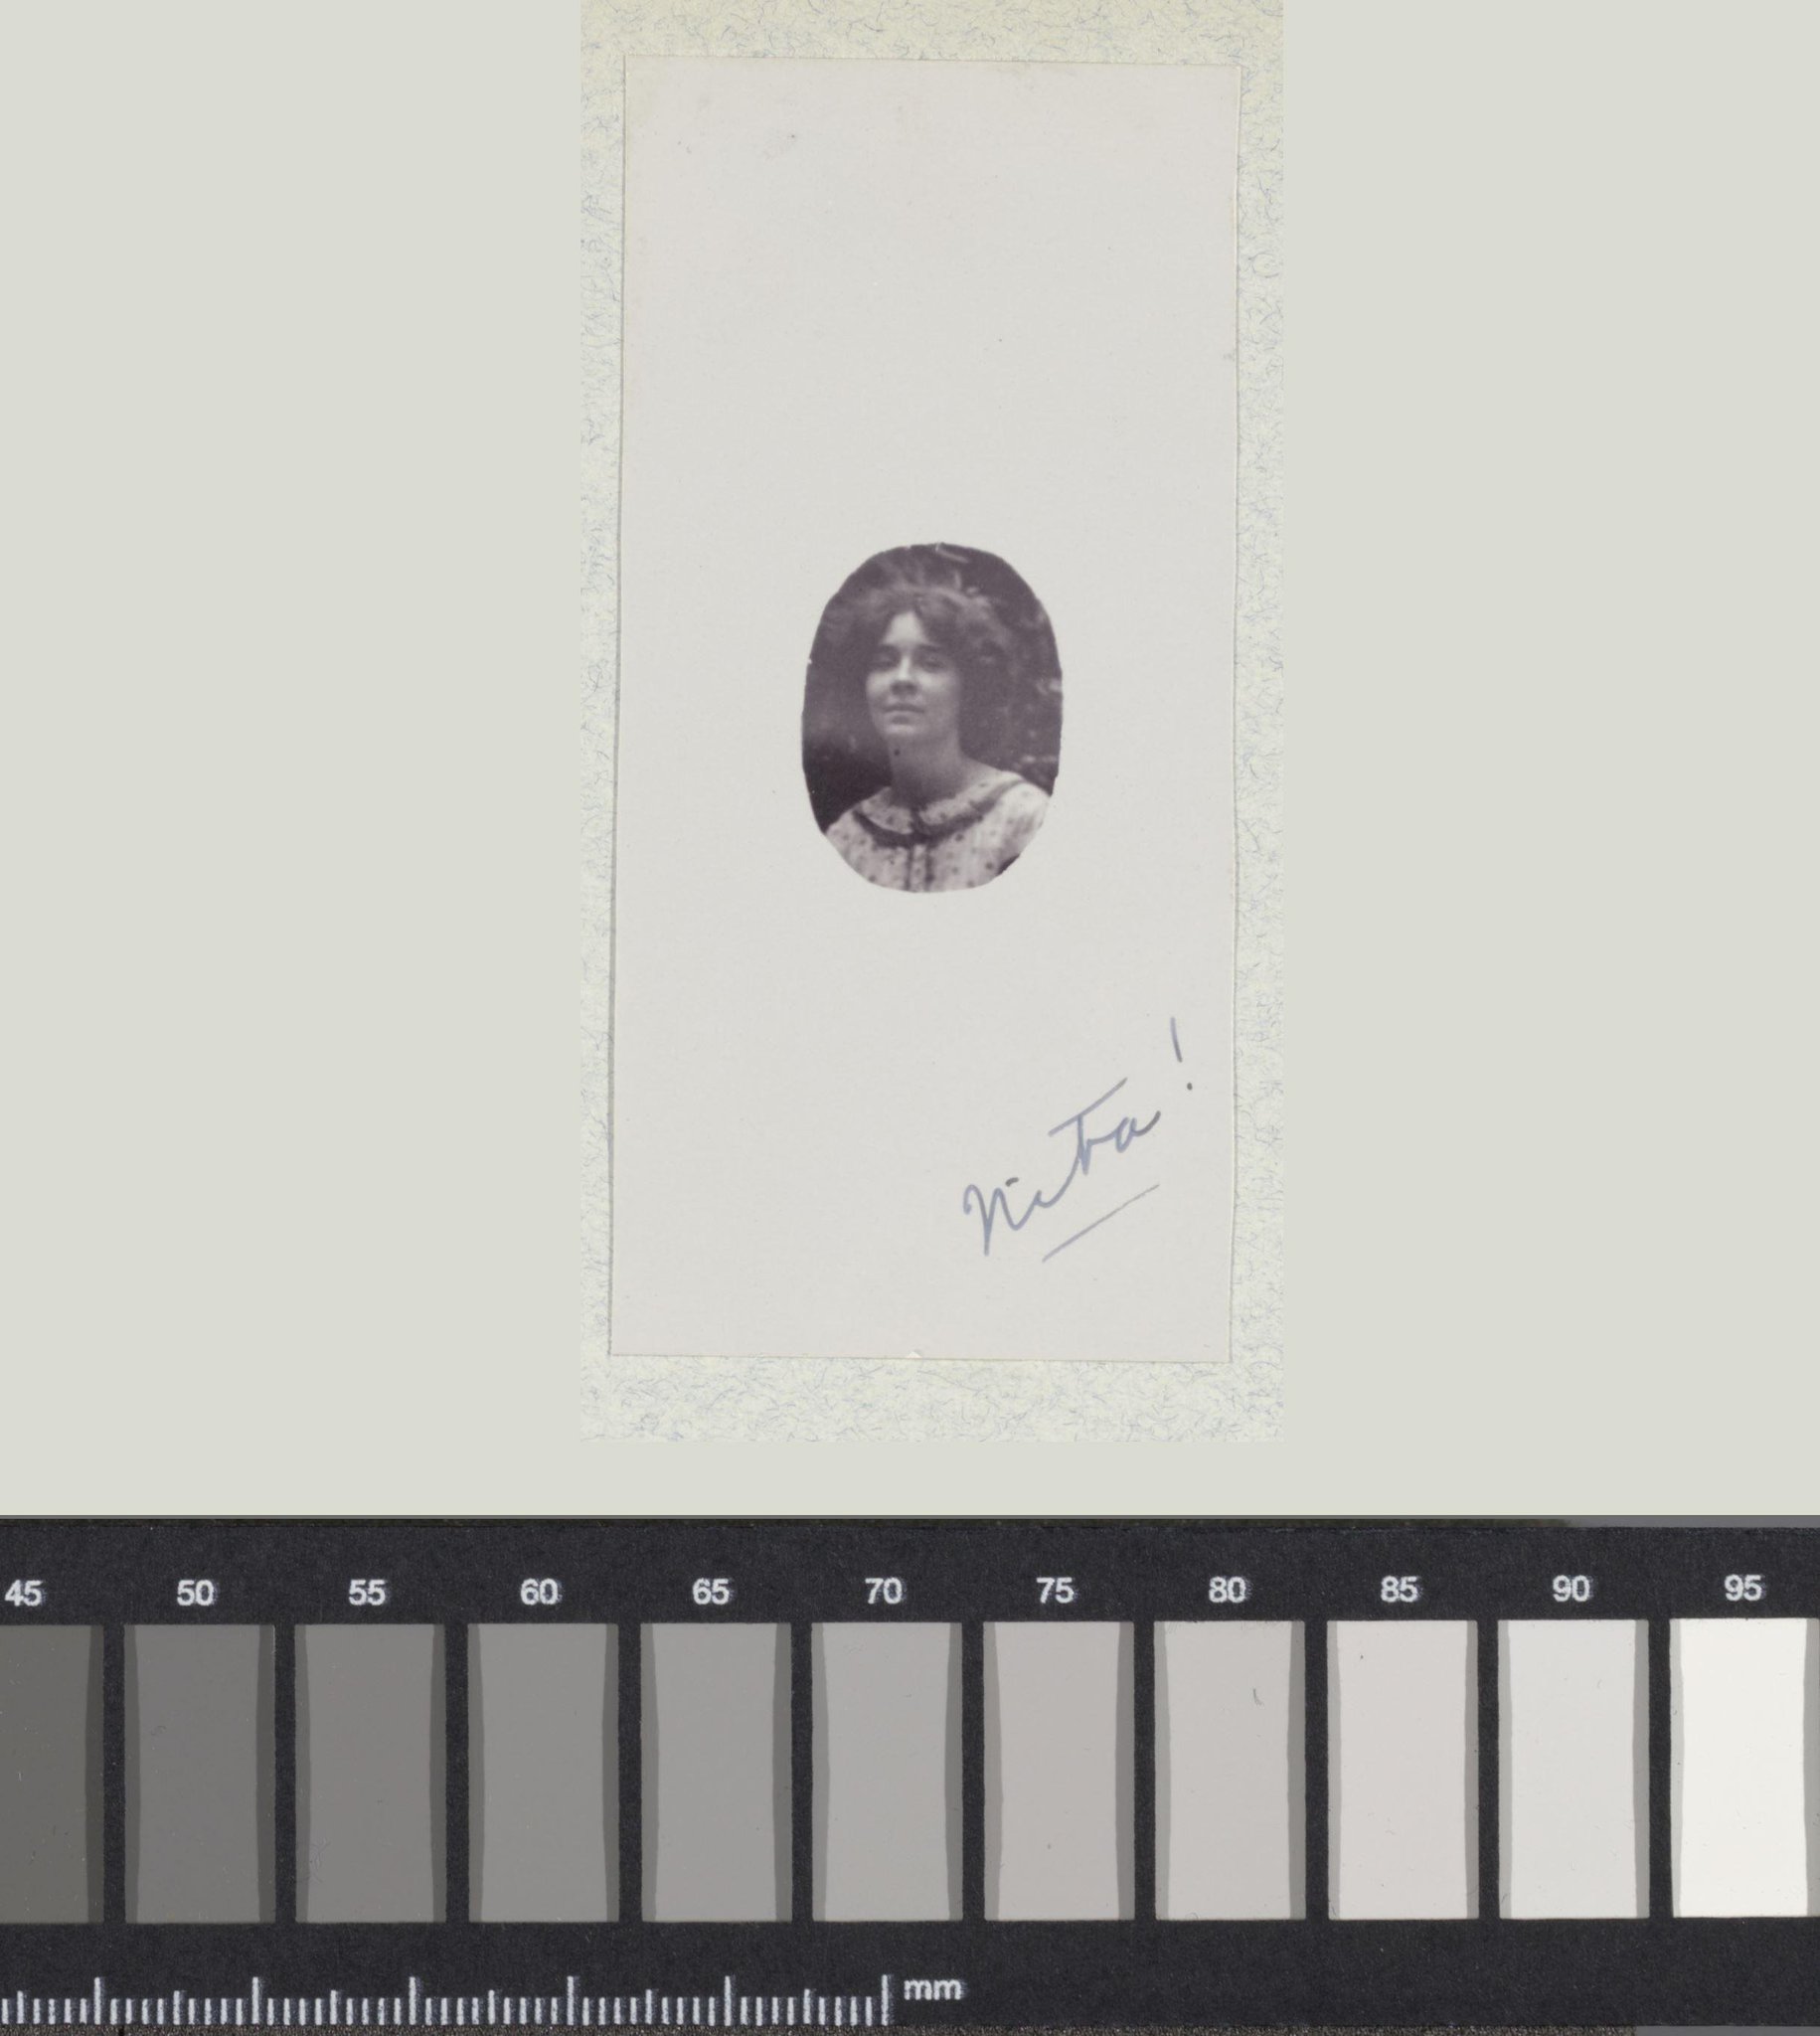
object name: photograph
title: Portret van Stephanie (Nita) Gonggrijp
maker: Anonymous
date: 1911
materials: photographic support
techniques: photography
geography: suriname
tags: suriname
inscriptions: inscription: ‘Nita!’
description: Ovaal portret van een jonge vrouw genaamd Stephanie (Nita) Gonggrijp van plantage Morgenstond. Onderdeel van het fotoalbum van de familie Boom-Gonggrijp in Suriname en Curaçao.